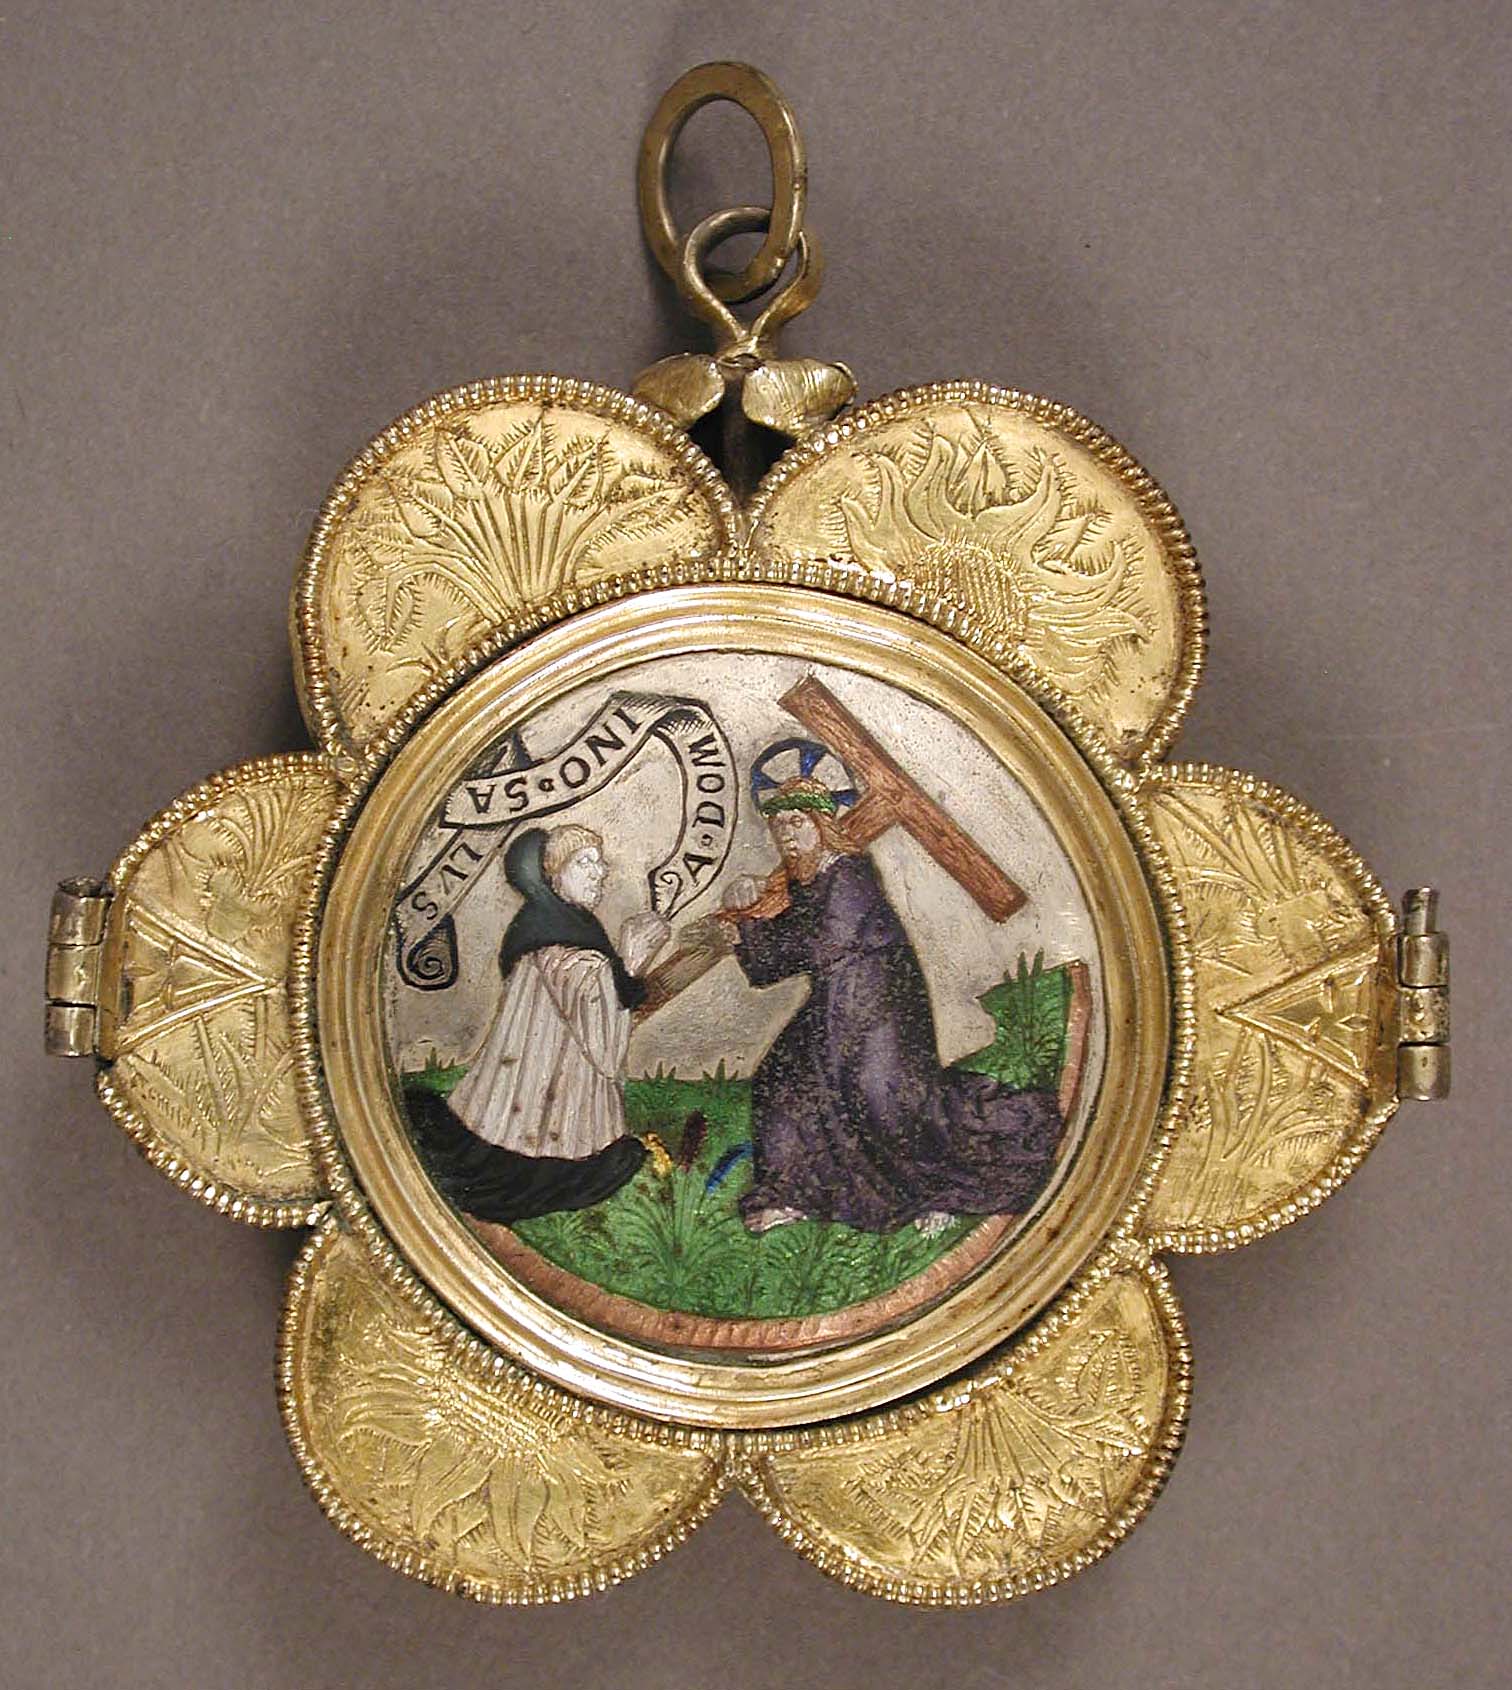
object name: reliquary pendant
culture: french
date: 1401-1500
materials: enamel, niello, silver, silver gilt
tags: christ,bearing the cross